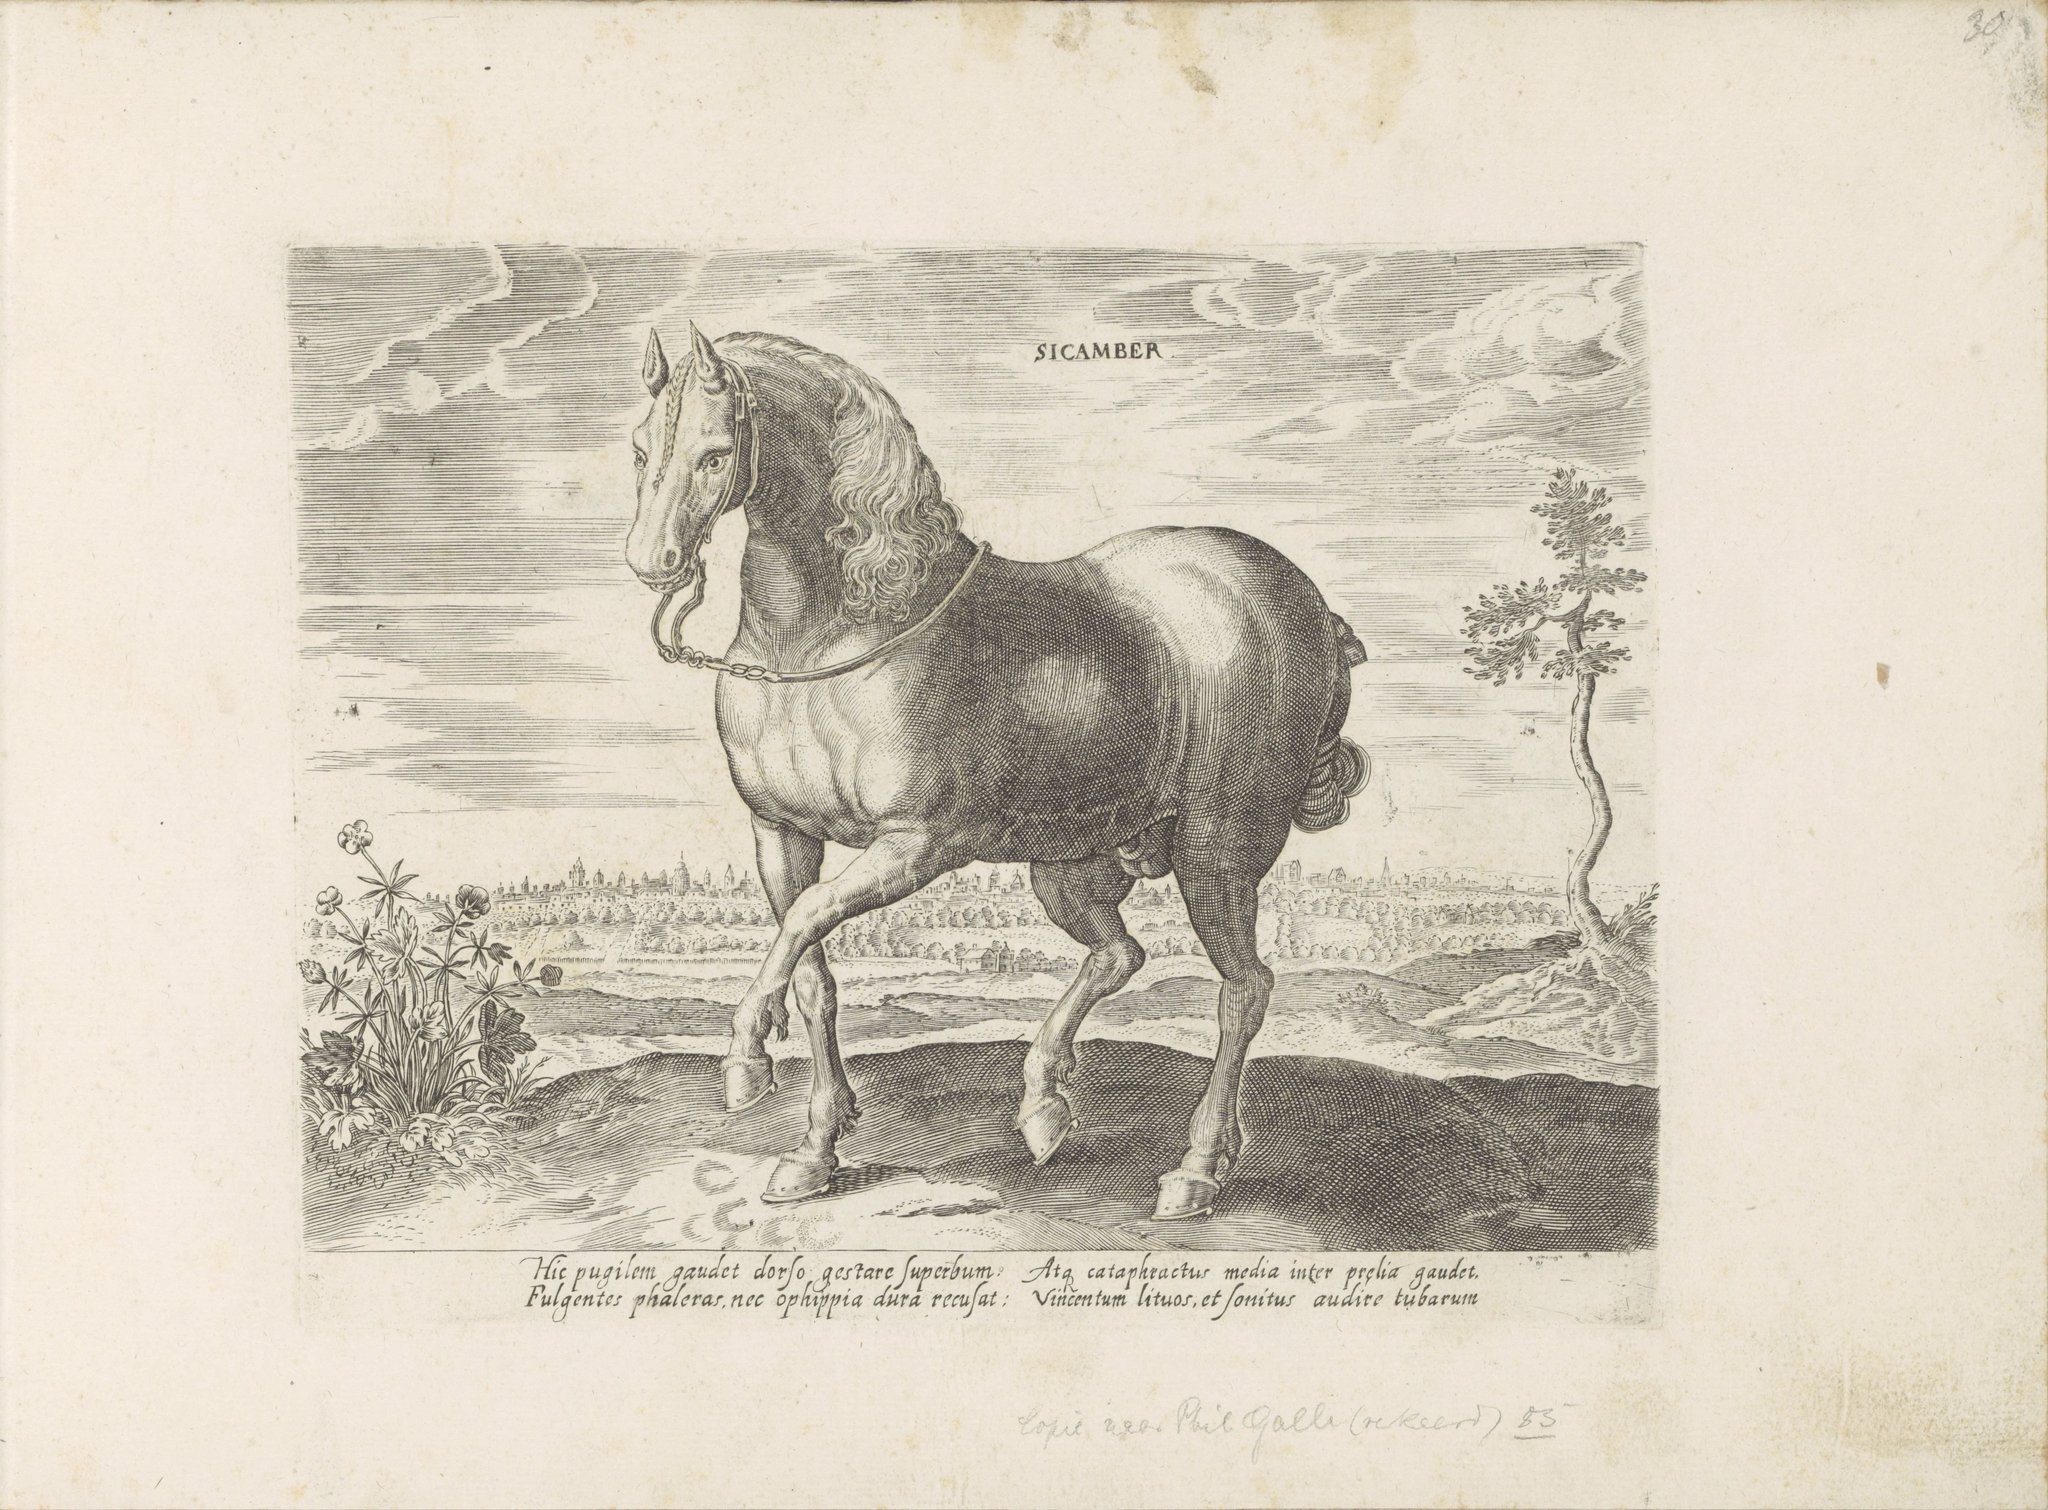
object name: print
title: Sicamber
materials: paper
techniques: engraving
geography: venice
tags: don juan van oostenrijk, horses and kindred animals, gelderland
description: Een Gelders paard in een landschap. Prent maakt deel uit van een album.